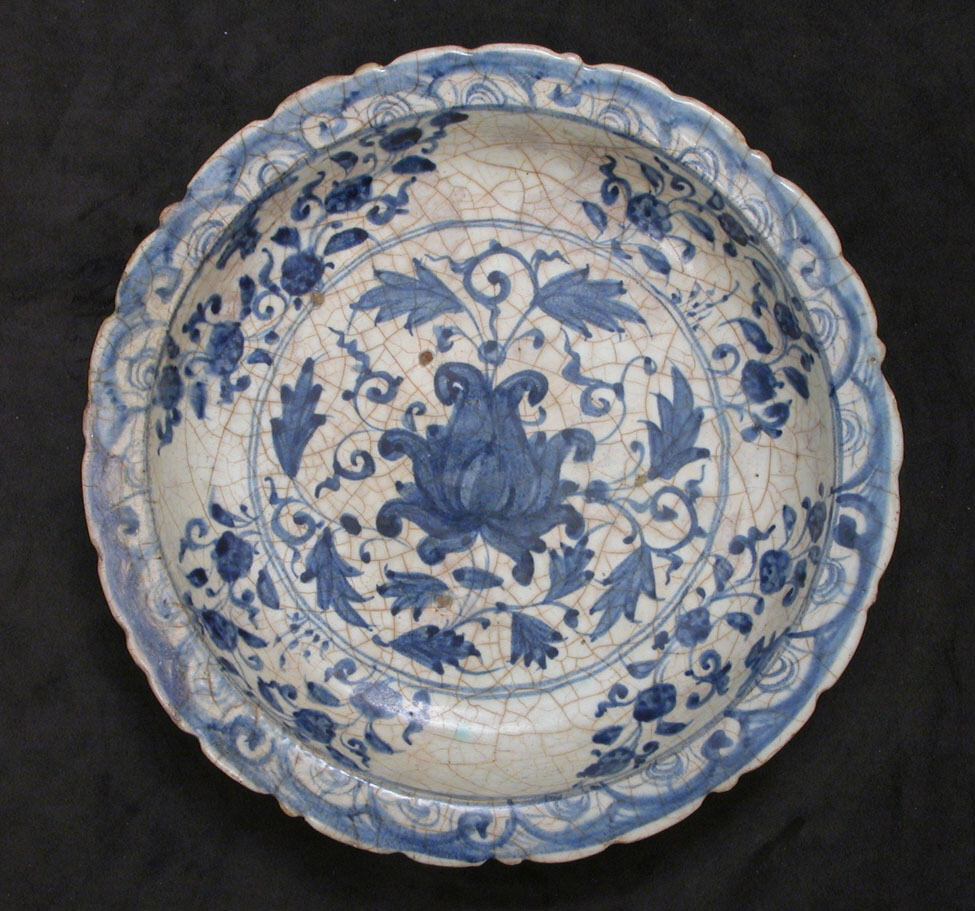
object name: dish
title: Dish with a Lotus Design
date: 1501-1600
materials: glaze, stonepaste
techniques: painting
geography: iran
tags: lotuses